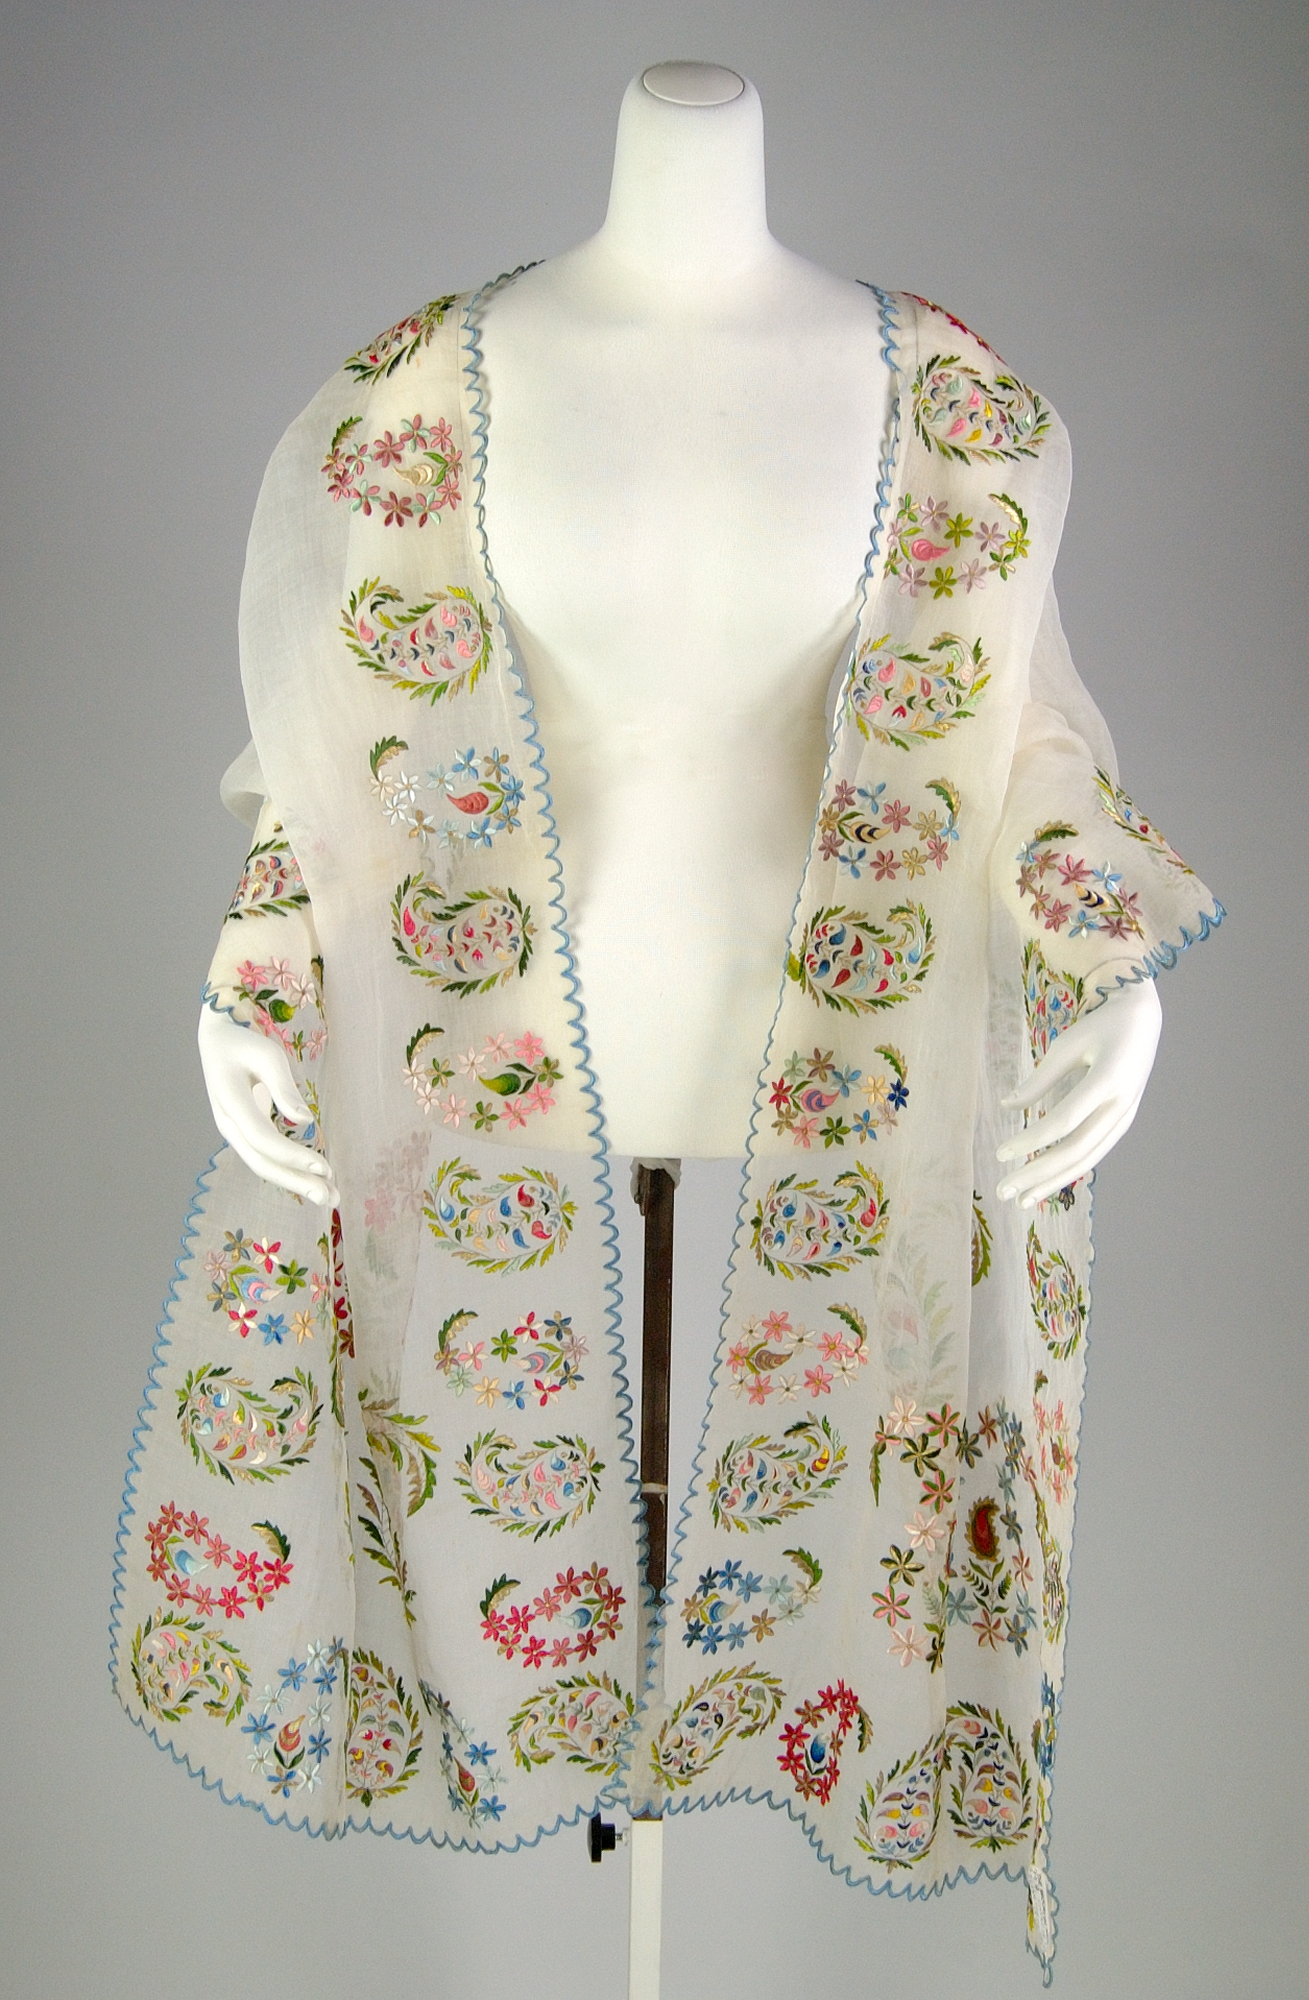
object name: stole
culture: chinese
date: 1851-1875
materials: cotton, silk